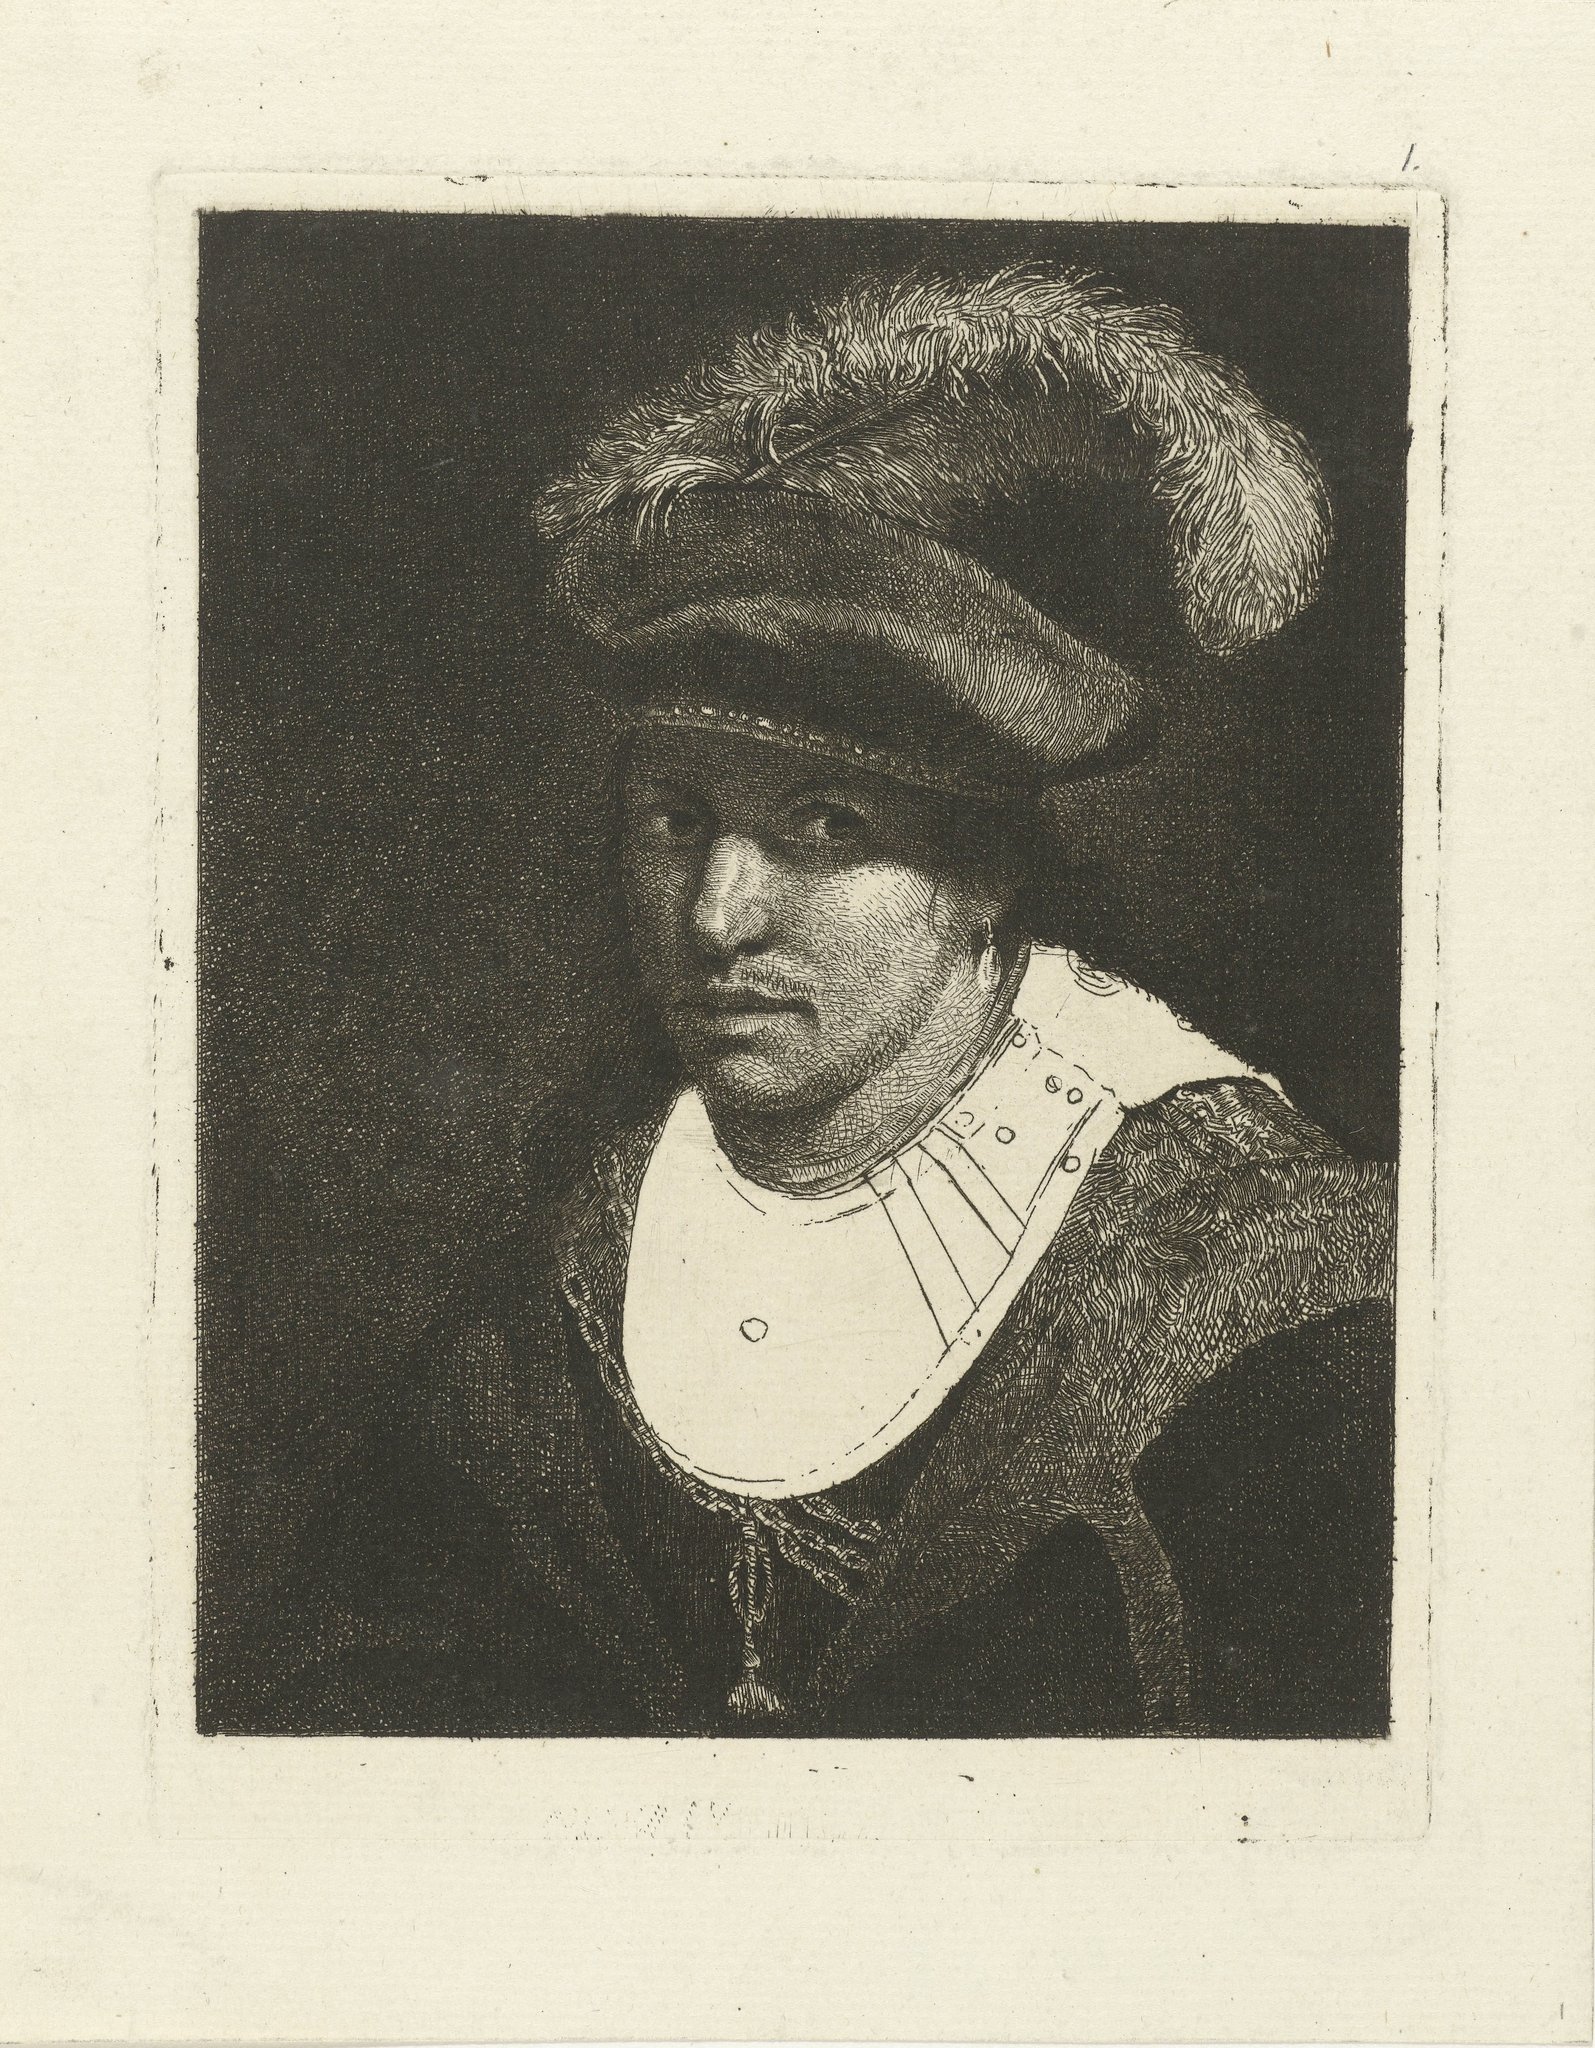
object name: print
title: Portret van onbekende man met gepluimde baret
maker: johannes pieter de frey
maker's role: draughtsman, print maker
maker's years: 1770-1834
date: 1780-1834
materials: paper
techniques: etching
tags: head-gear: beret (+ men's clothes)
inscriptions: number: ‘1’, collector's mark: Lugt 12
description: Portret van een onbekende man, ten halven lijve naar links. Zijn baret is getooid met een veer.